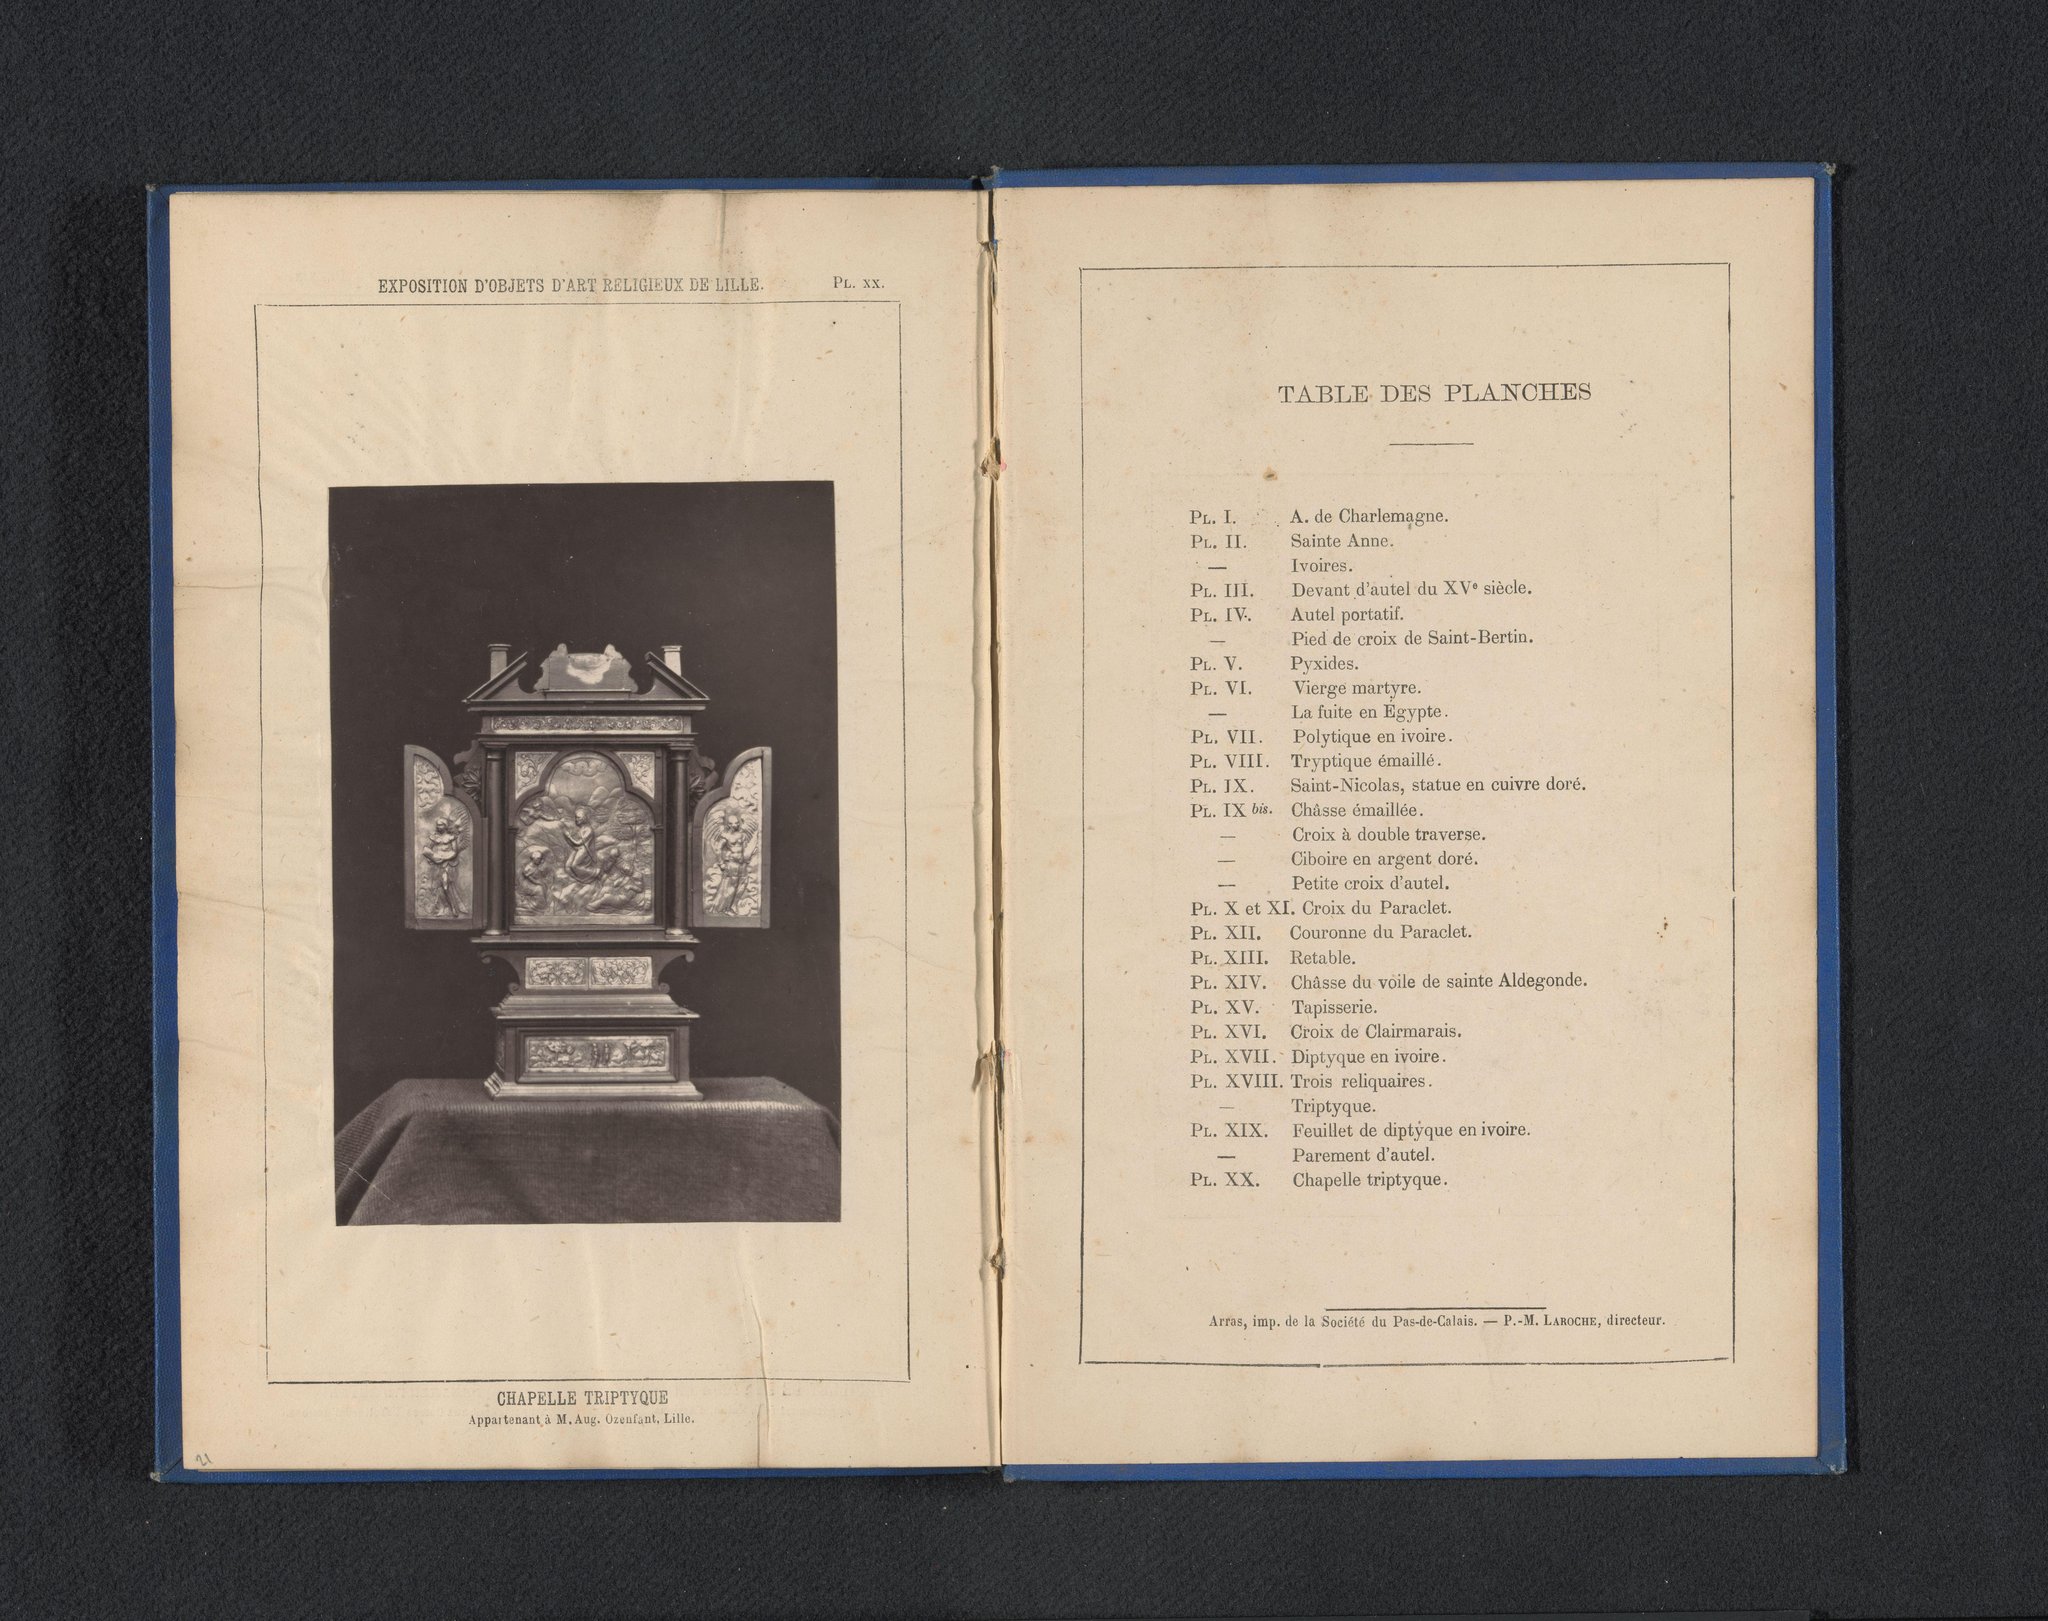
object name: page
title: Chapelle triptique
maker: Anonymous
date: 1871-1876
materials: cardboard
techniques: woodburytype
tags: sculpture (+ relief ~ sculpture)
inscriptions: inscription: ‘Exposition d'objets d'art religieux de Lille’, inscription: ‘Appartenant à M. Aug. Ozenfant, Lille’, inscription: ‘Pl. XX.’